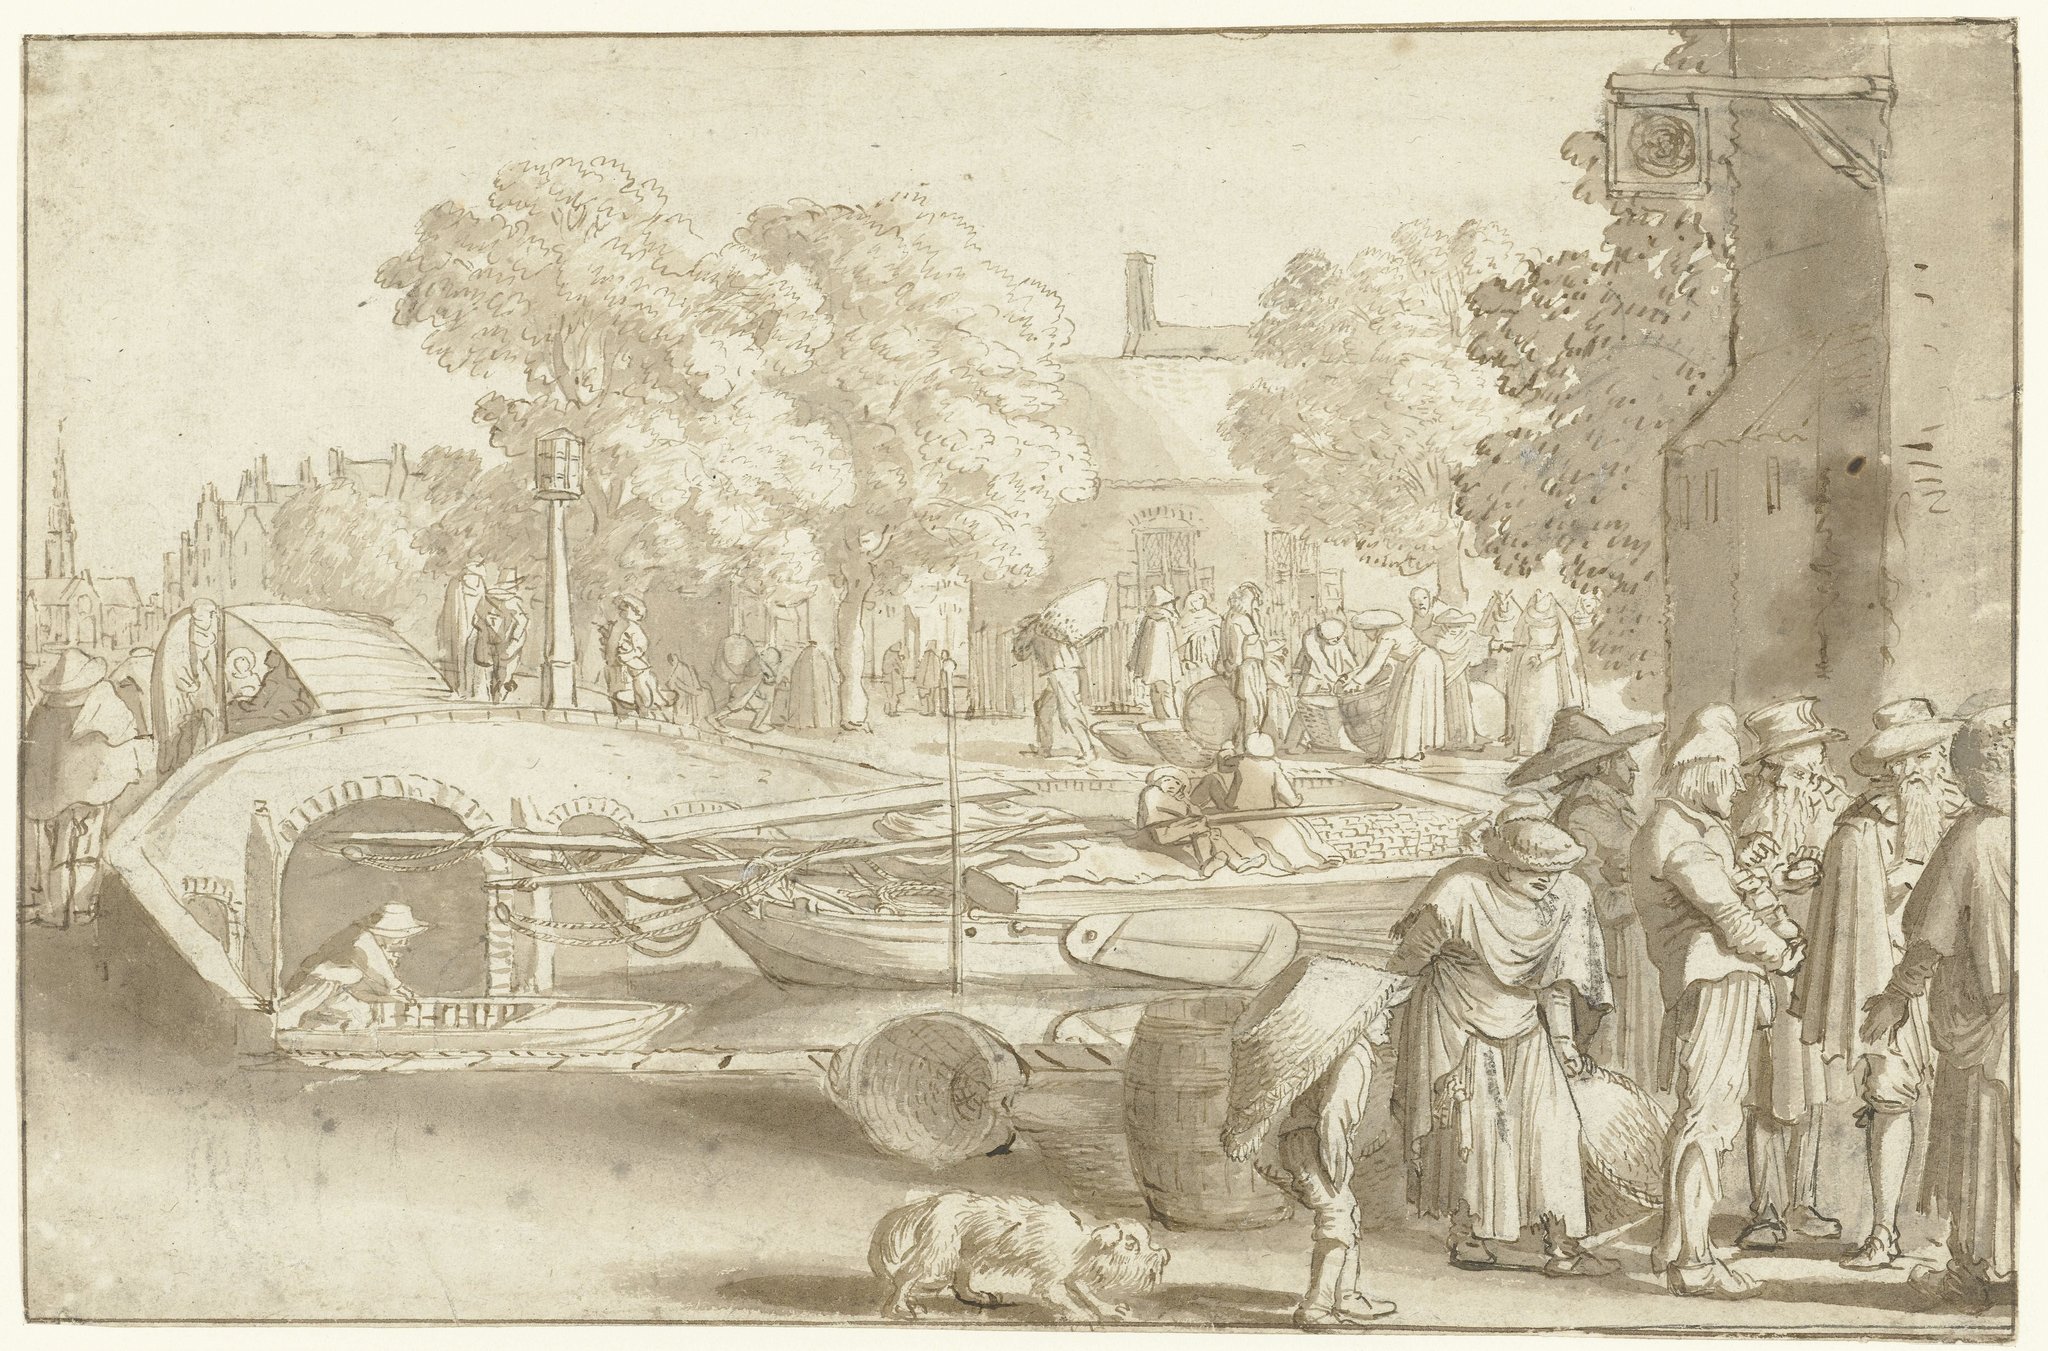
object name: drawing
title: Marktscène bij een gracht te Haarlem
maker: jan van de velde (ii)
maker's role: draughtsman, painter, print maker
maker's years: 1593-1641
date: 1603-1641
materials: chalk, paint, ink, paper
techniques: brush, pen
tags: canals, waters (in city), market, haarlem